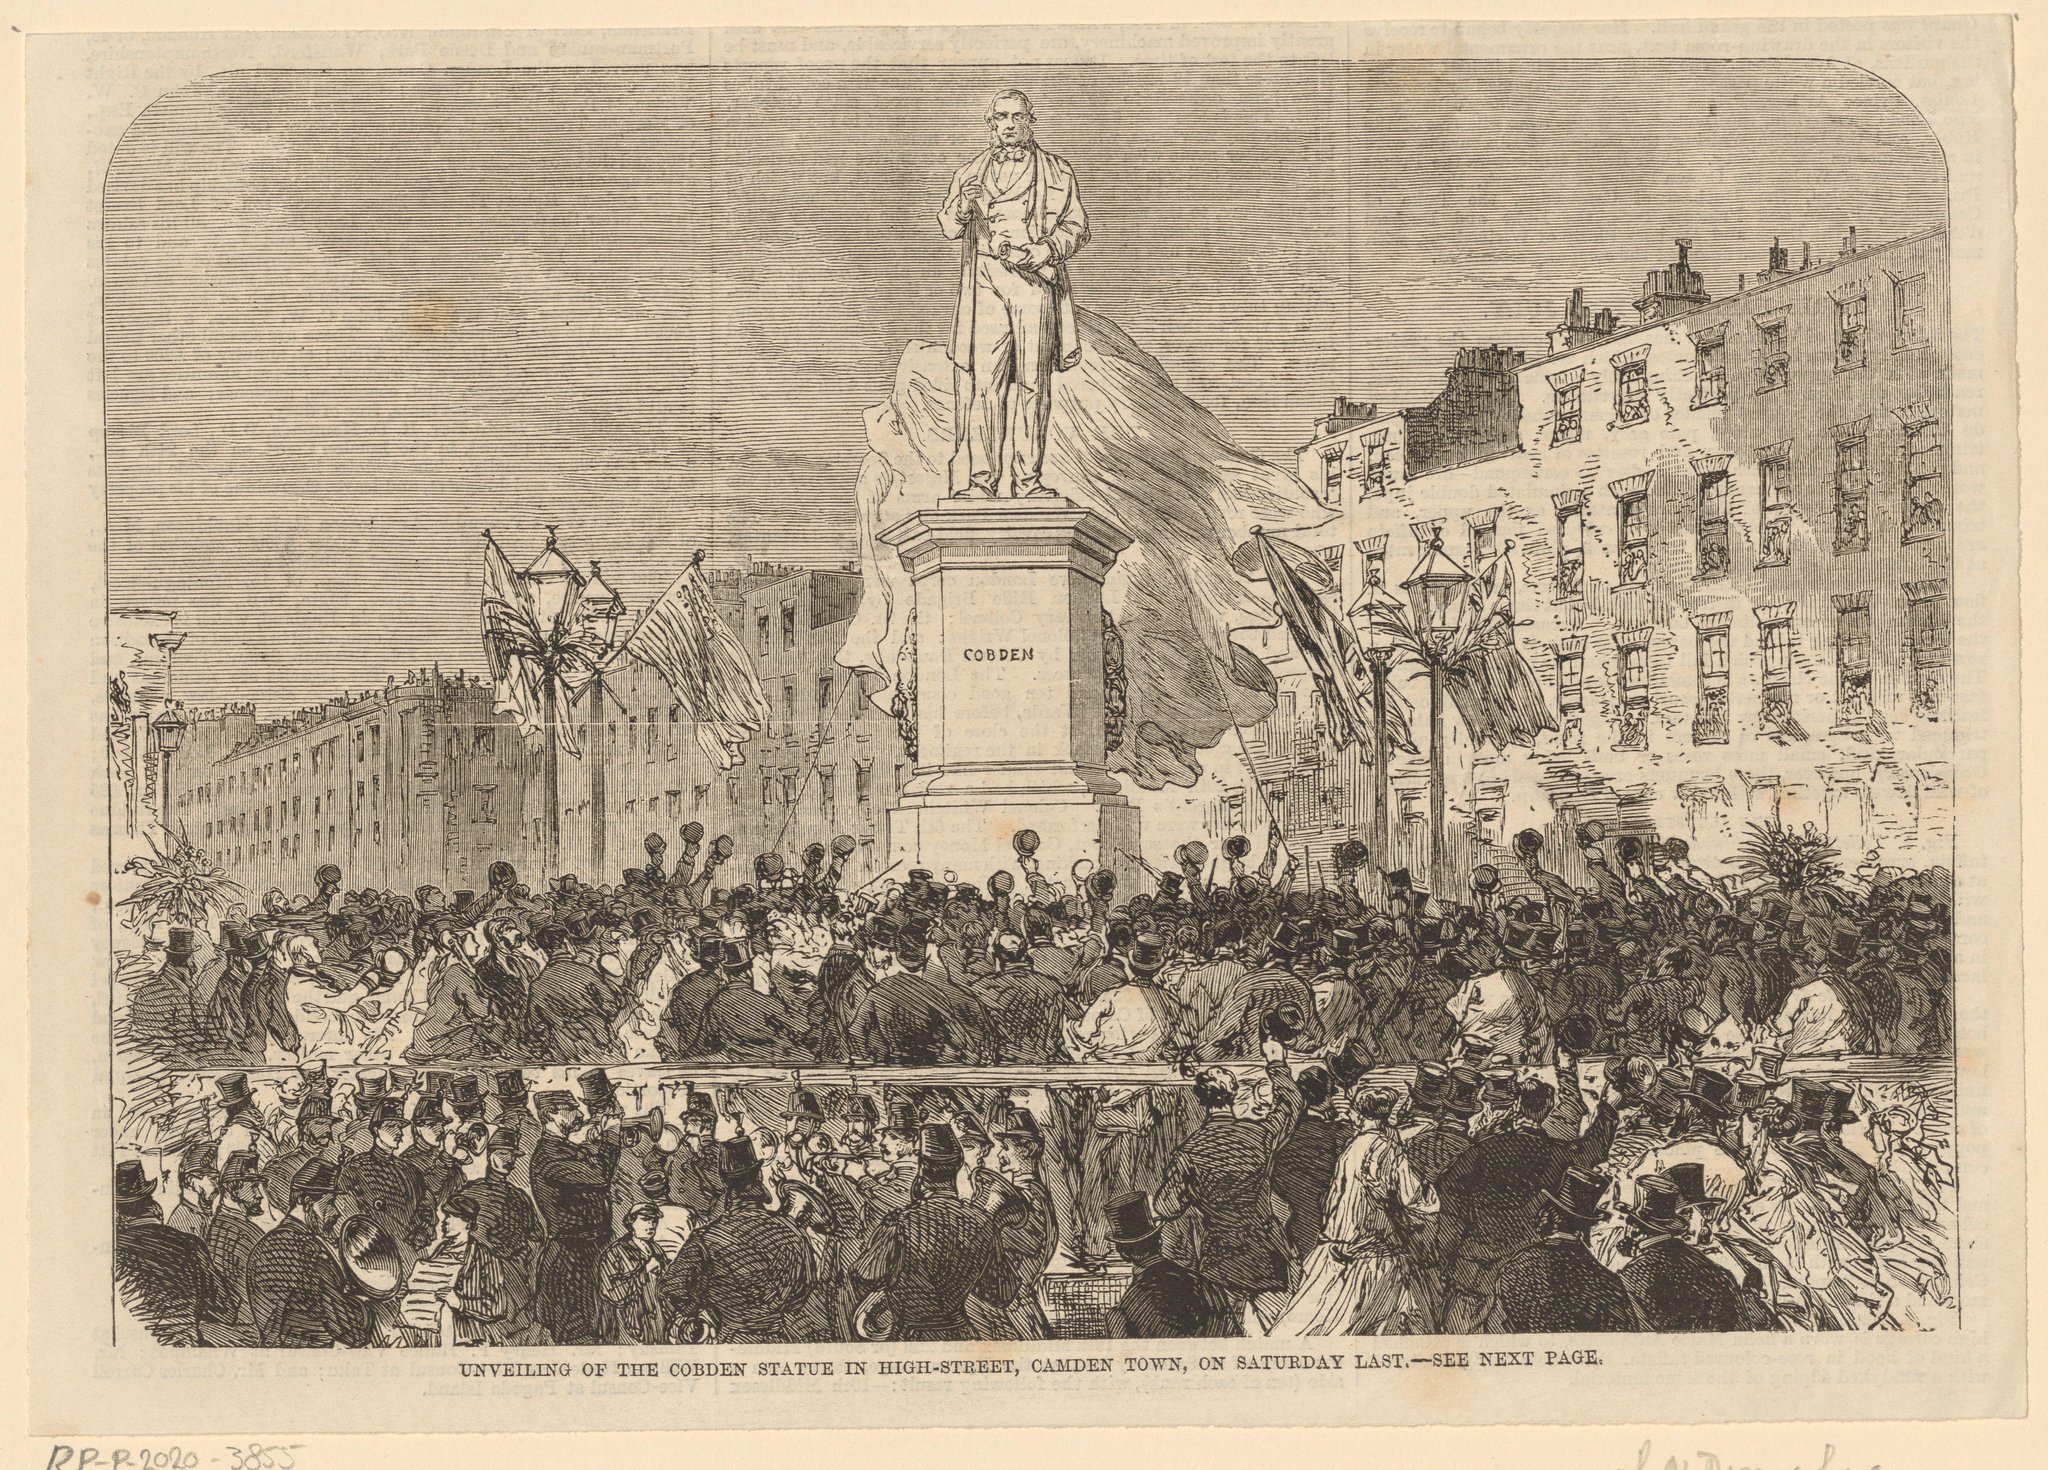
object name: print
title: Onthulling van het standbeeld van Richard Cobden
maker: Anonymous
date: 1868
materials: paper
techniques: letterpress printing, engraving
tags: manufacturer, historical persons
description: Prent mogelijk uit: The Courier and Argus from Dundee, 29 juni 1868.